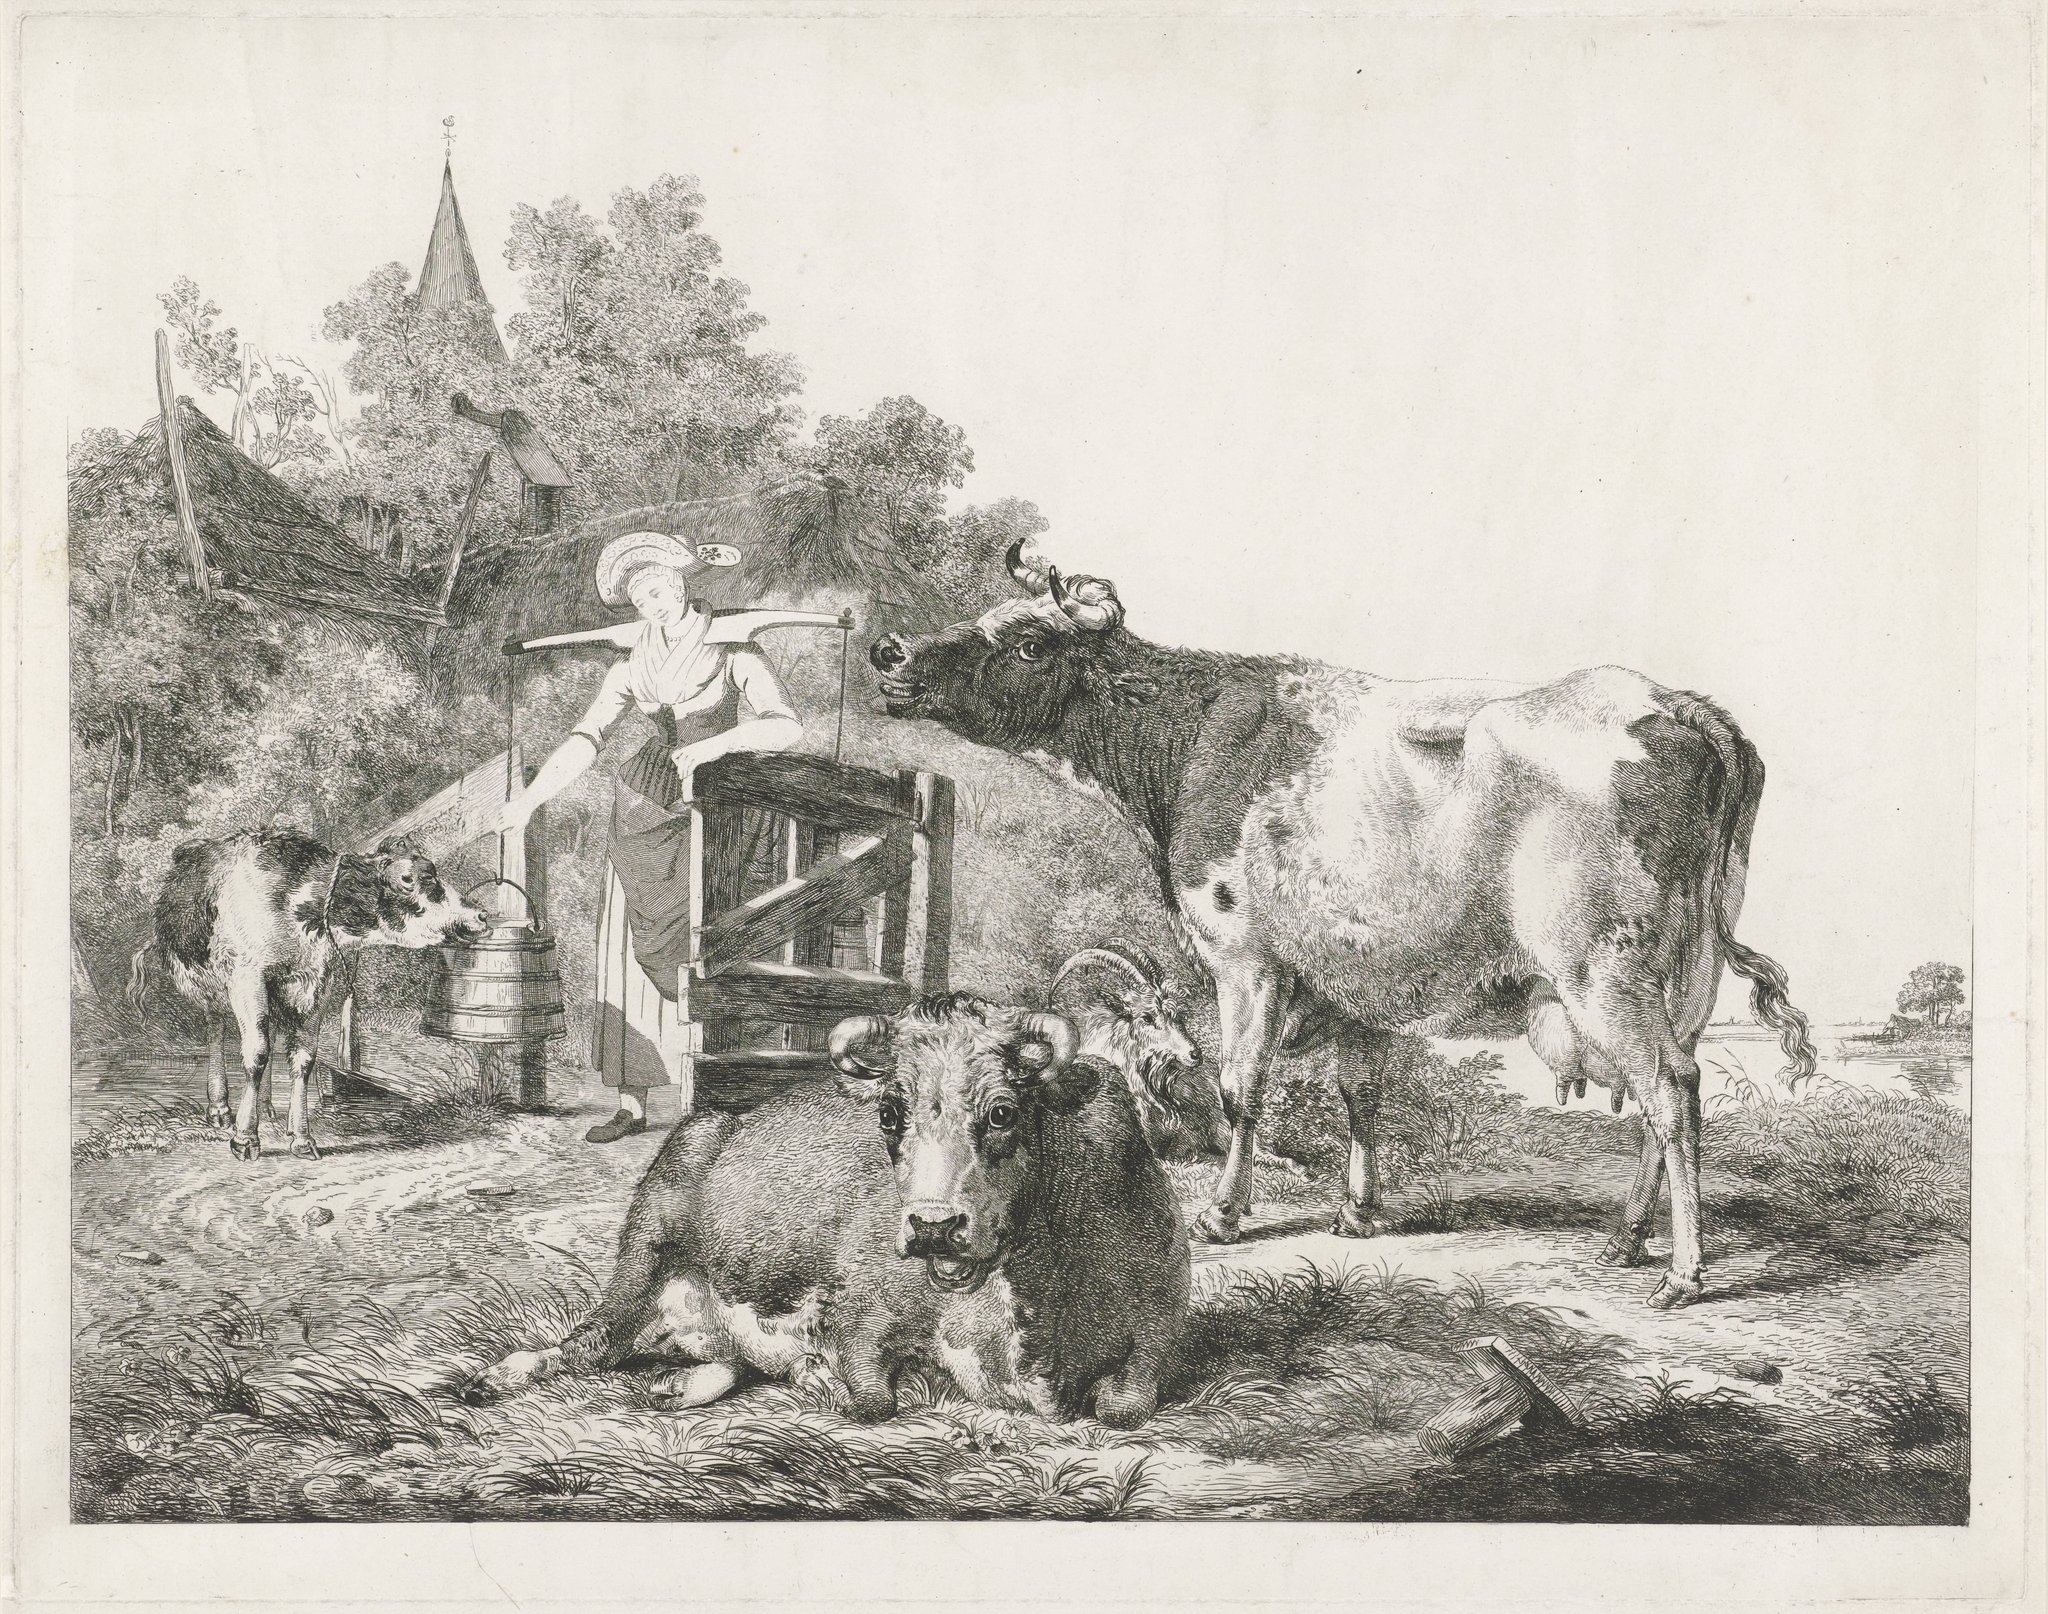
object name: print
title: Melkmeisje met drie koeien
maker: pieter gerardus van os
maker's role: draughtsman, painter, print maker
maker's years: 1776-1839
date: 1791-1839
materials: paper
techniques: etching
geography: netherlands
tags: milkmaid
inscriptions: collector's mark: Lugt 2228